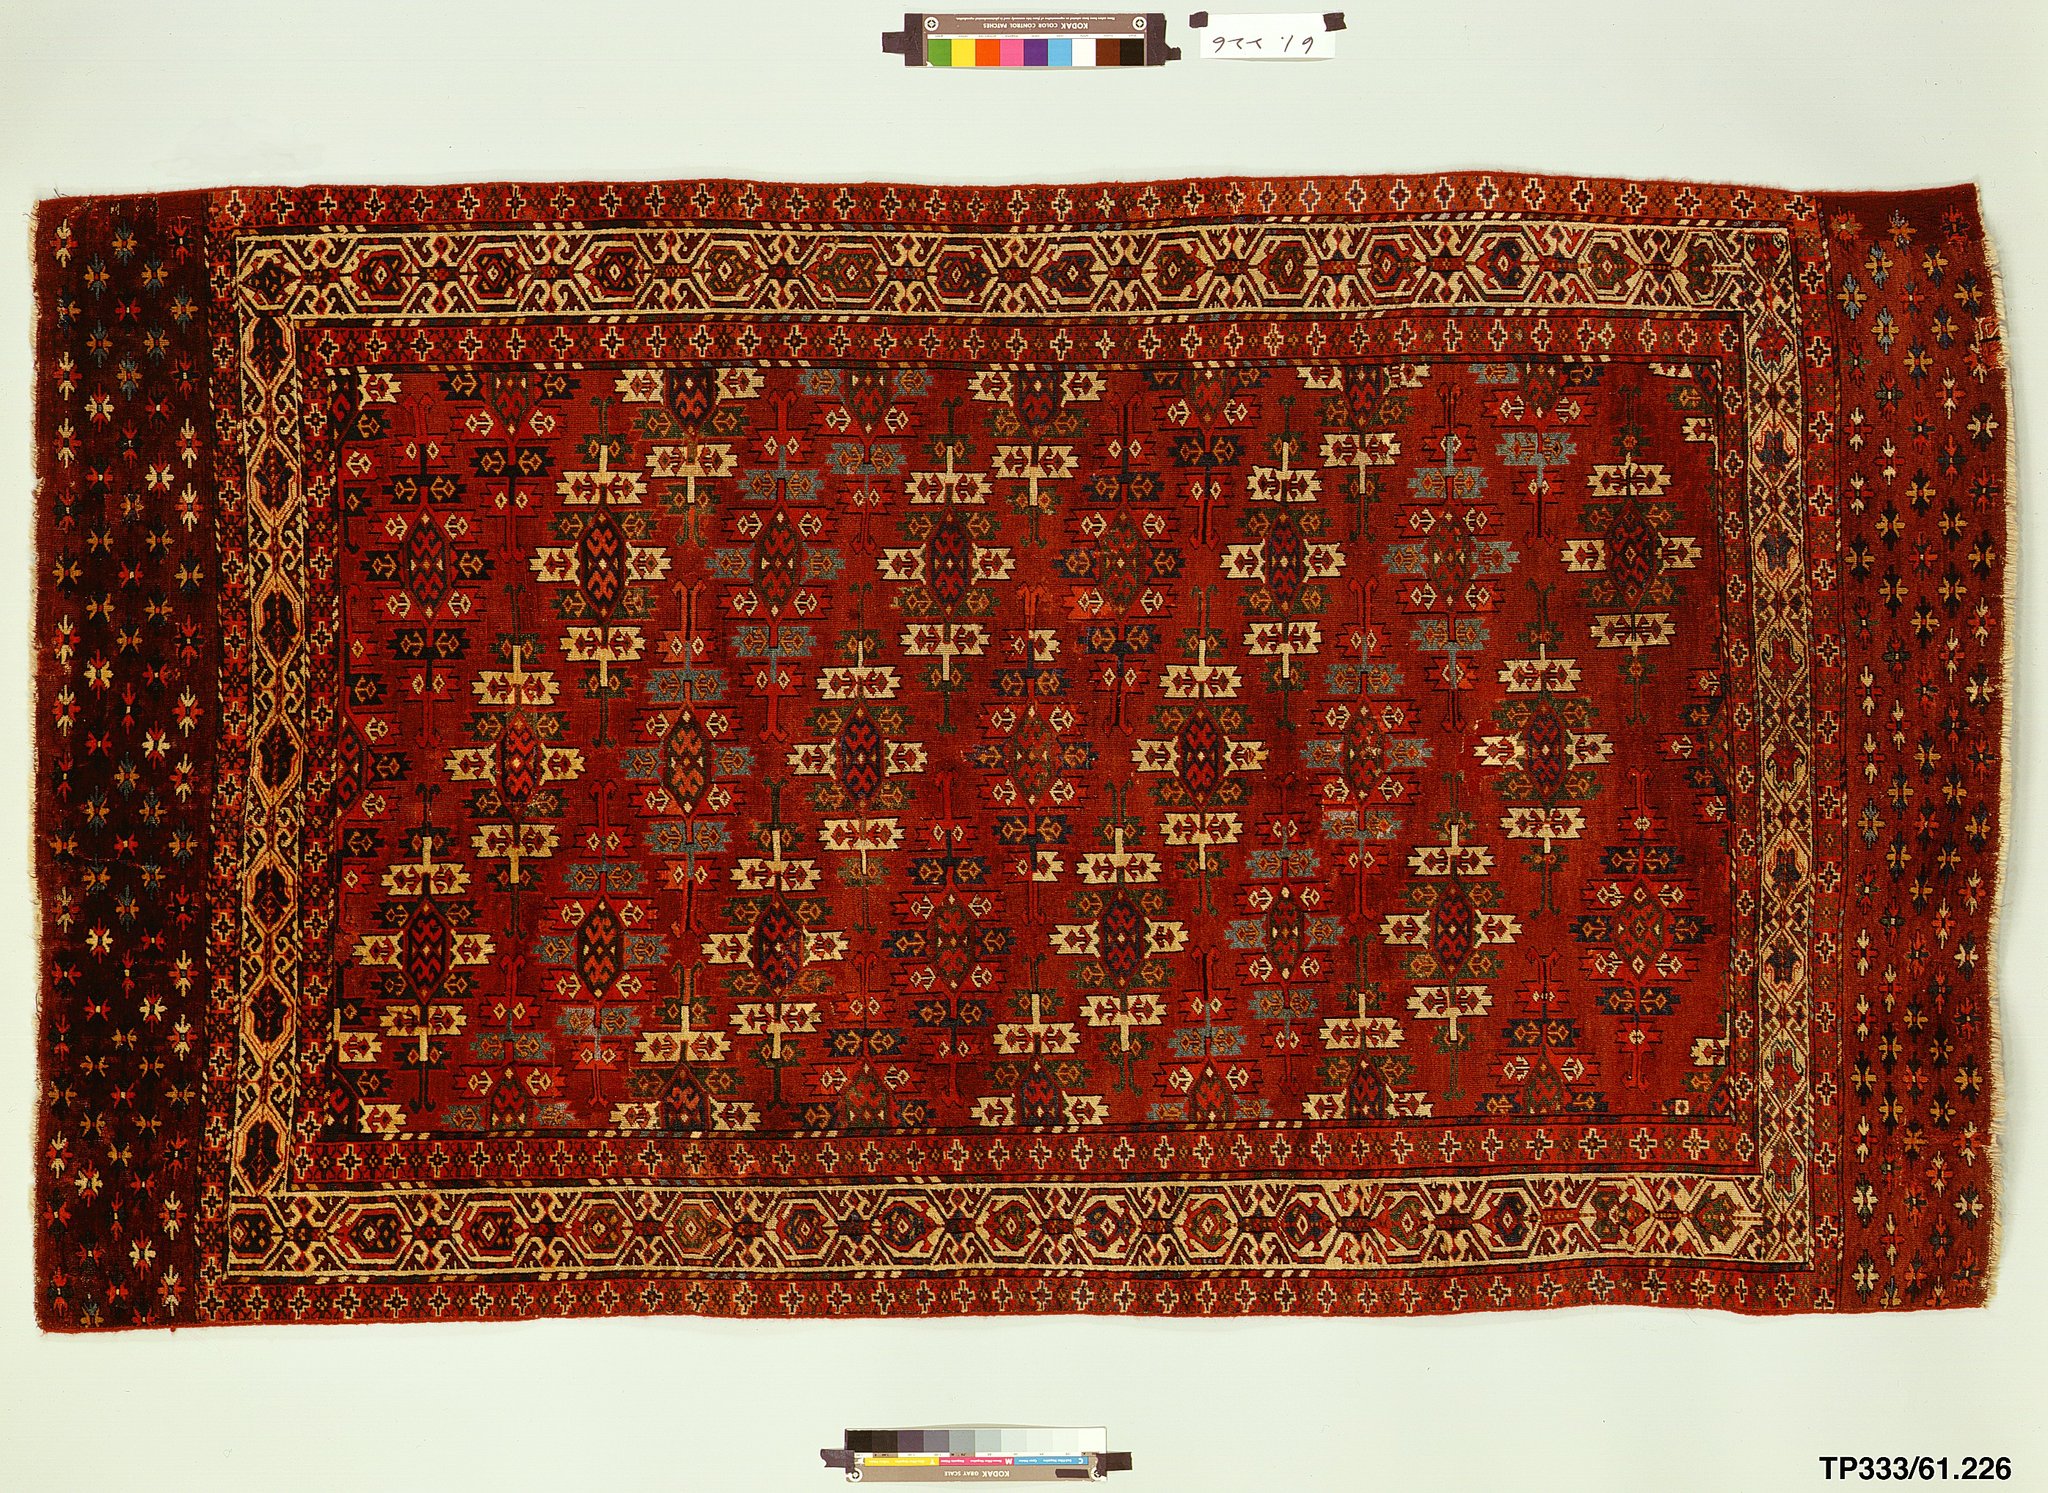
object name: carpet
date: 1801-1850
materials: wool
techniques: pile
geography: turkmenistan